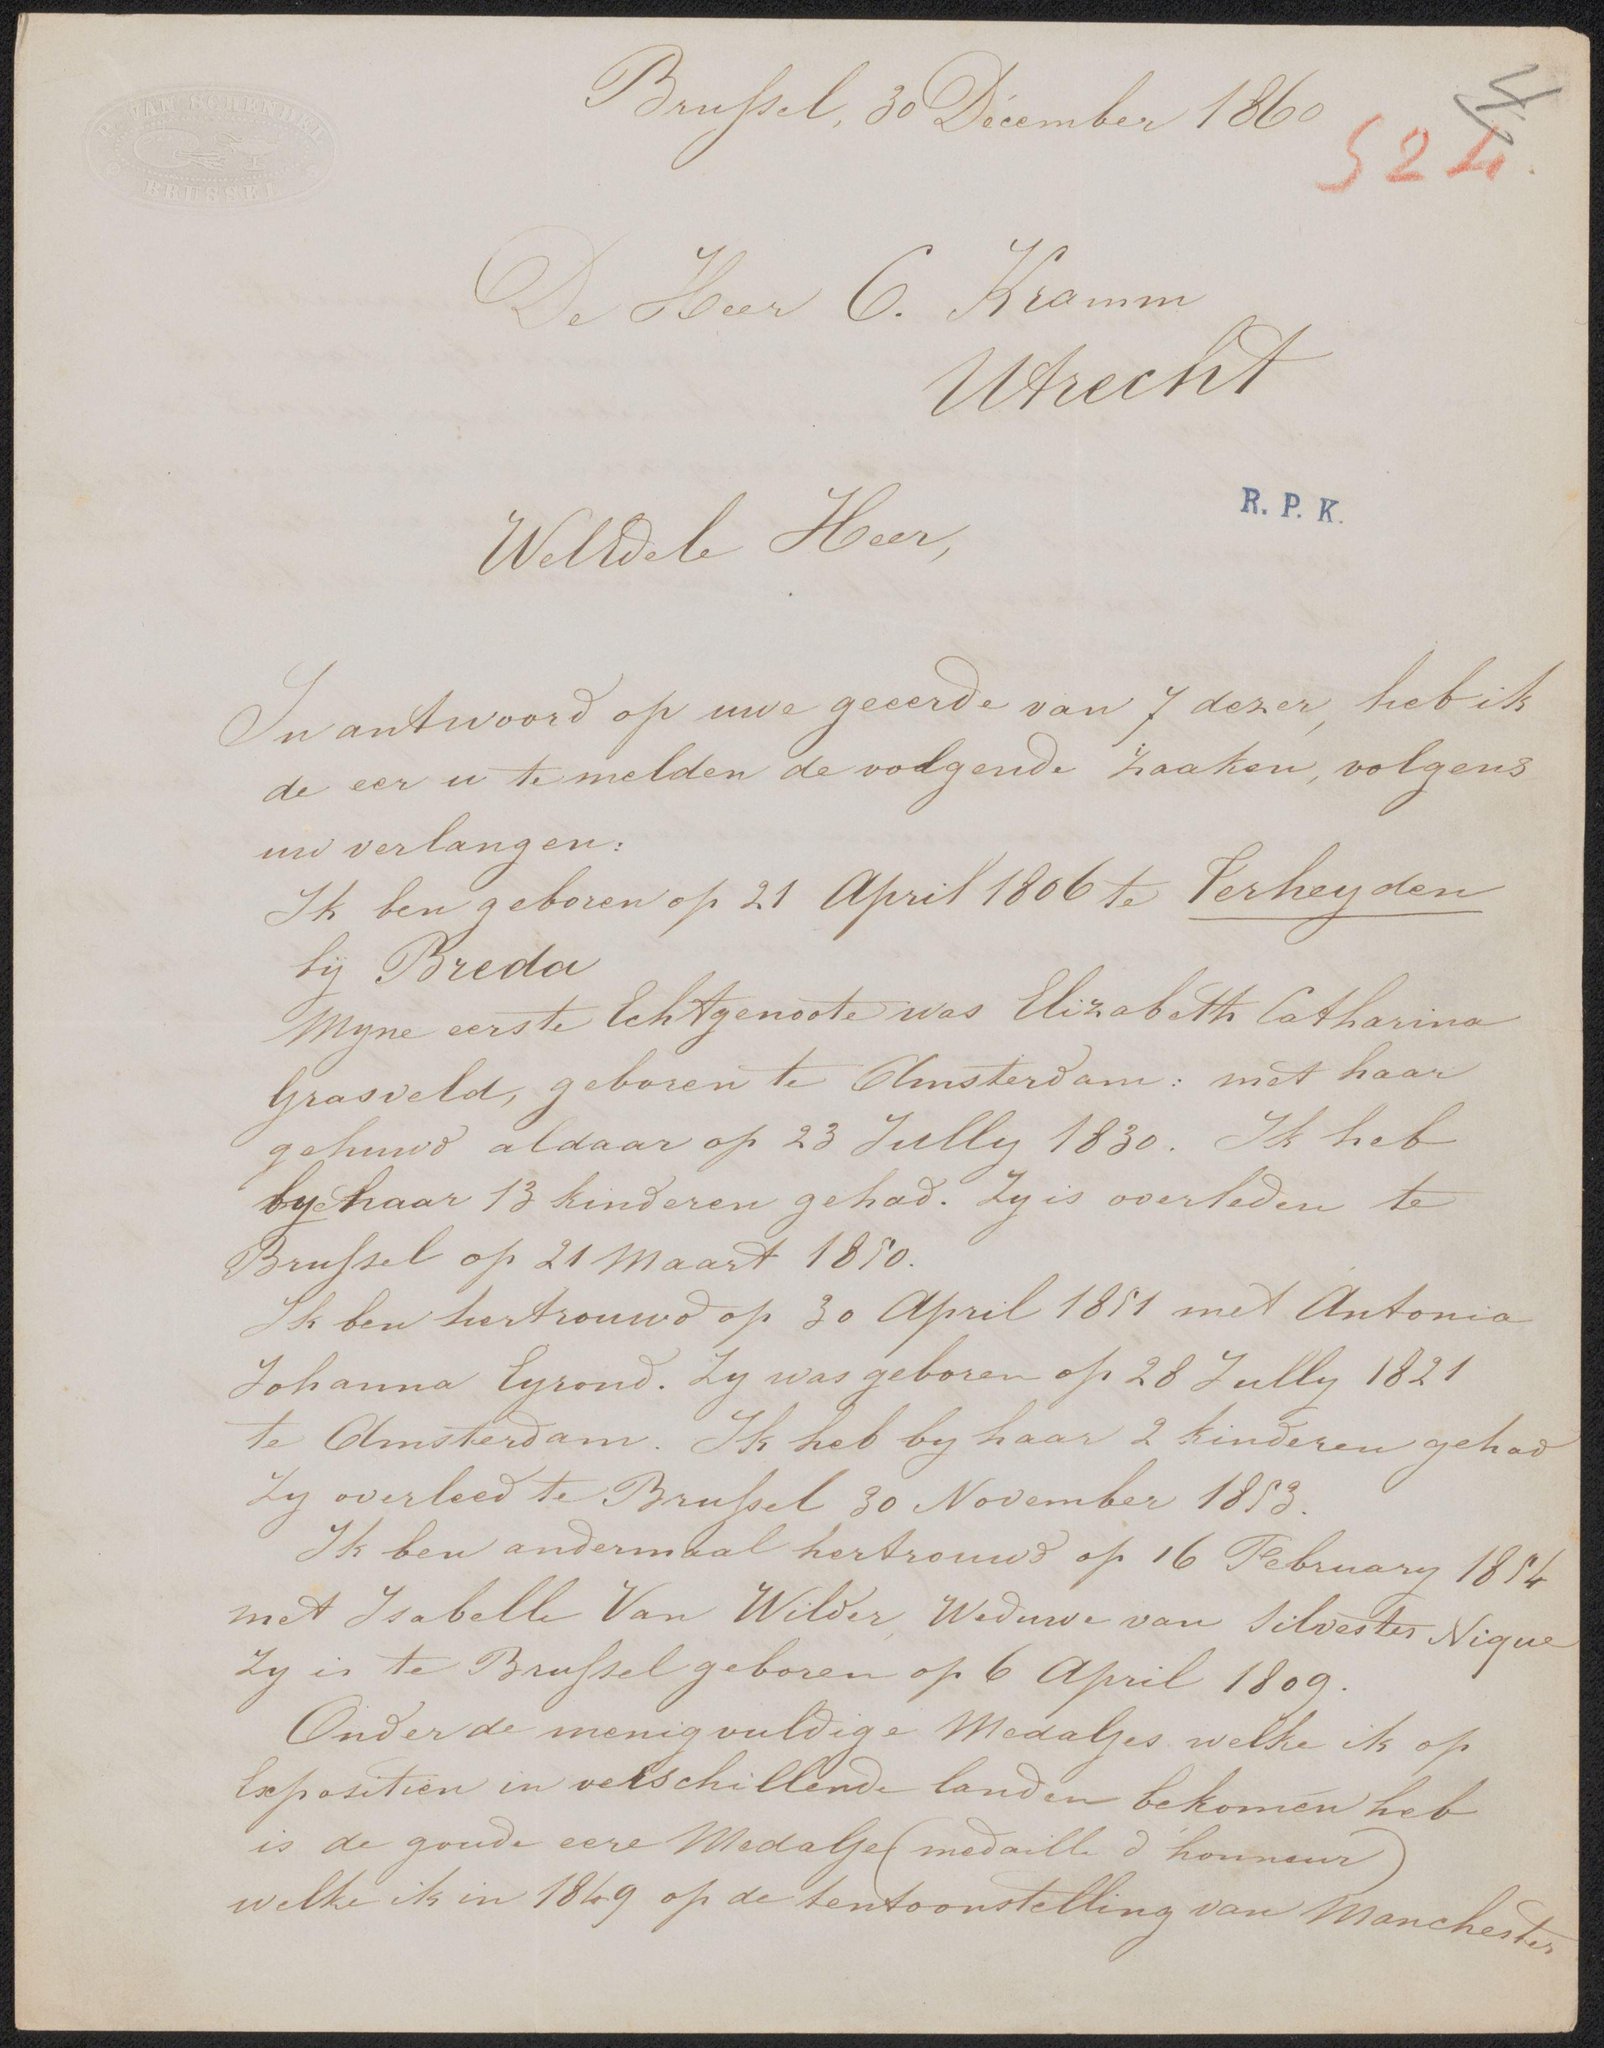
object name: letter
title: Brief aan Christiaan Kramm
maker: petrus van schendel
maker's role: draughtsman, painter, print maker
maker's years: 1806-1870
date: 1860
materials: ink, paper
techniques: pen, writing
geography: brussels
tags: utrecht, christiaan kramm, art trade, art shop, distribution of awards ~ art contest, family life, painting (including book-illumination, miniature-painting), exhibition ~ art, art collecting, printed matter, manchester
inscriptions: collector's mark: Lugt 2233